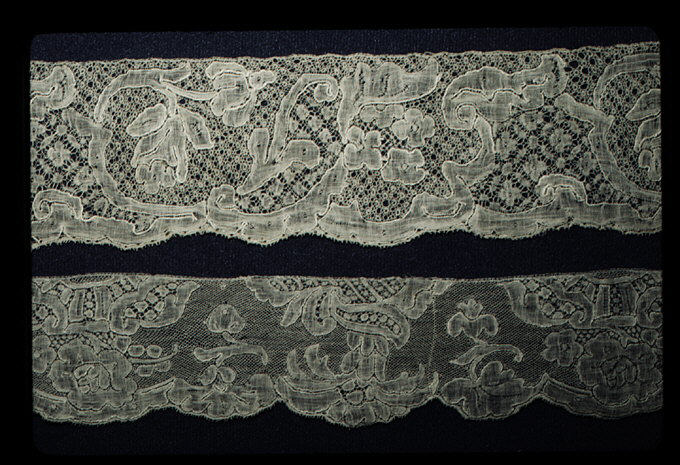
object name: strip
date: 1701-1733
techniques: lace